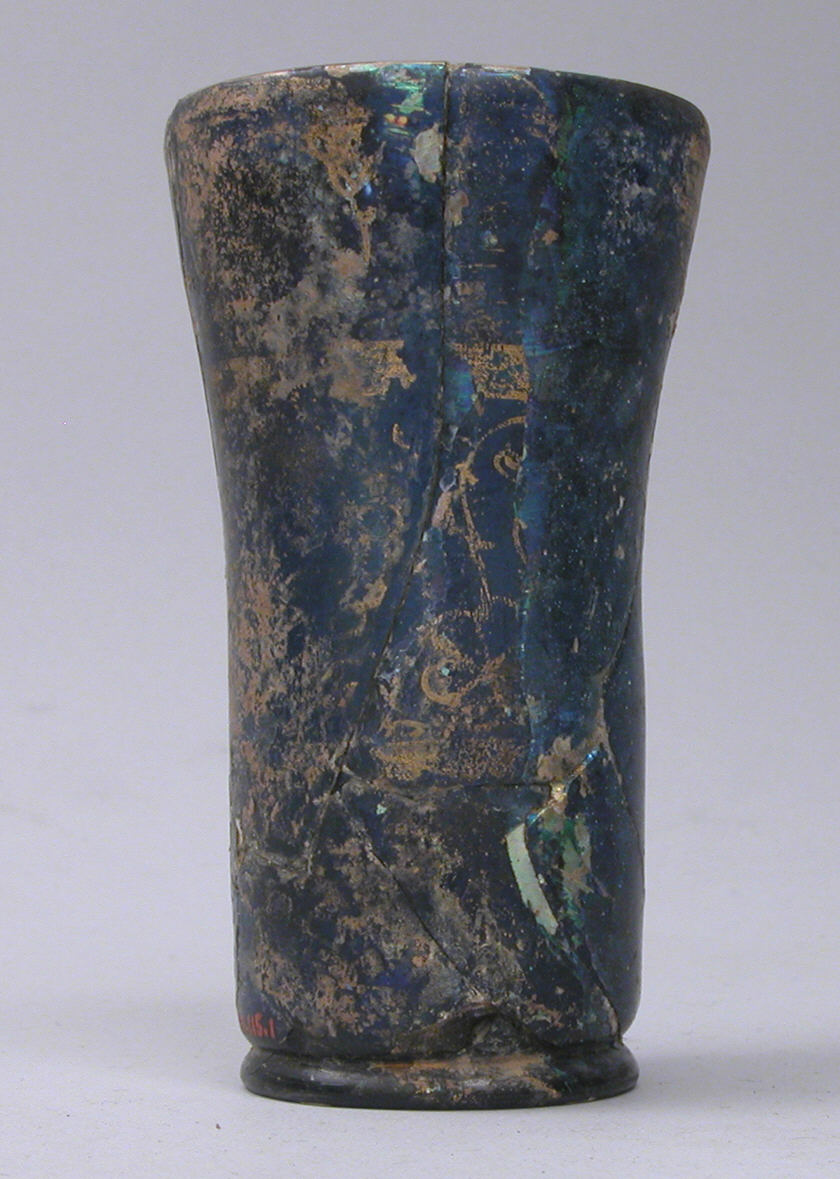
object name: beaker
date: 1201-1300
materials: glass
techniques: glassblowing, gilding, tooling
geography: syria